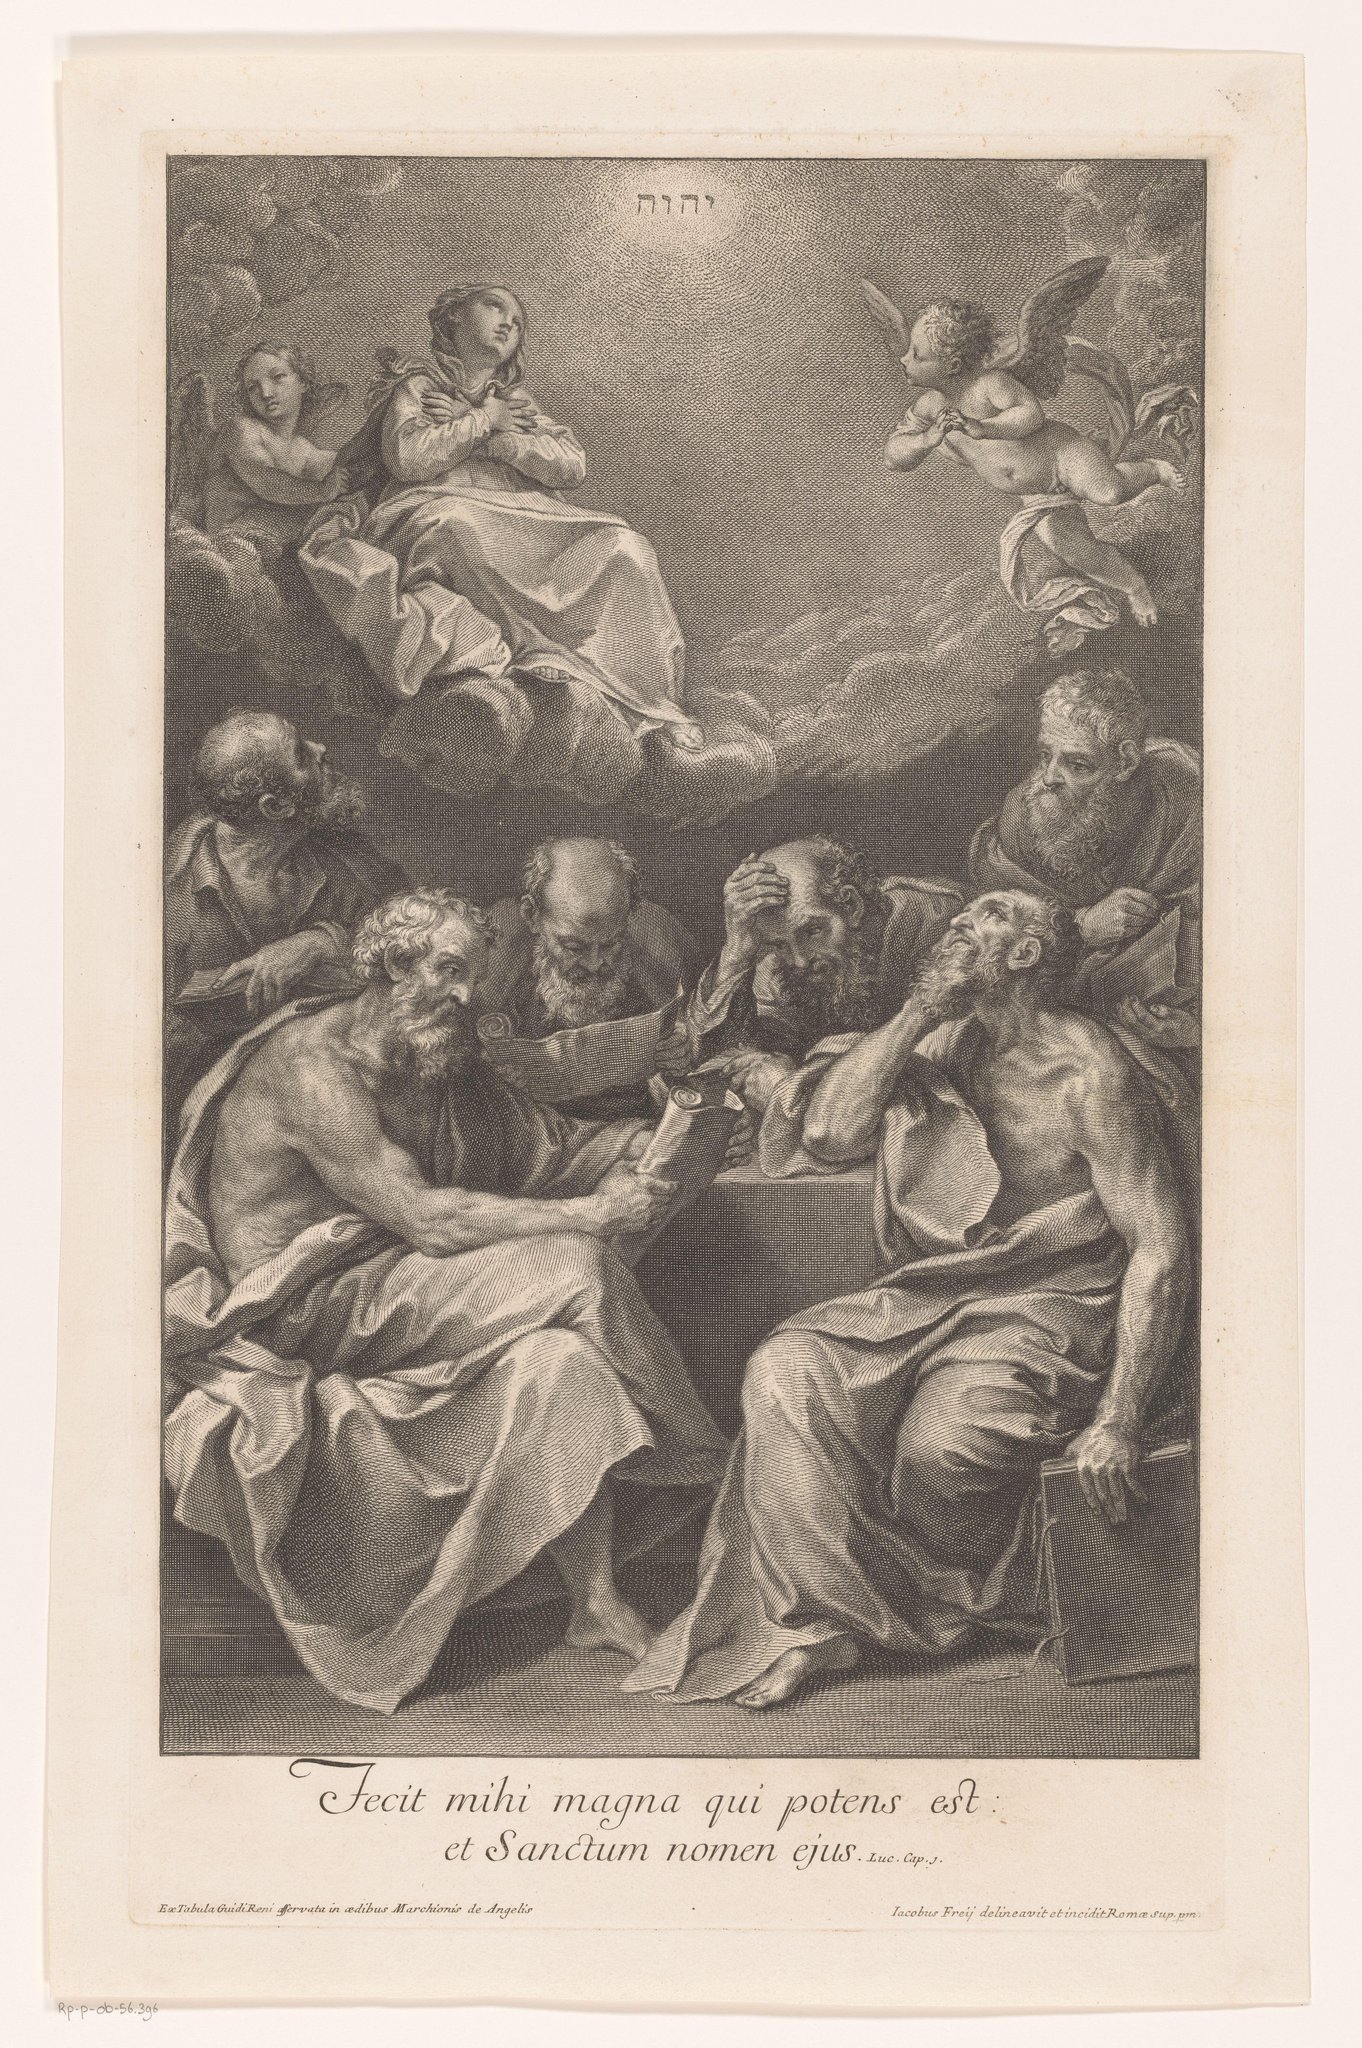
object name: print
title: Kerkvaders in beraad over de onbevlekte ontvangenis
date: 1728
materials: paper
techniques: engraving, etching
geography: rome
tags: (immaculate) conception of mary represented symbolically, doctors (fathers) of the church, tetragram (in hebrew script) ~ jewish religion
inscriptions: collector's mark: Lugt 2228